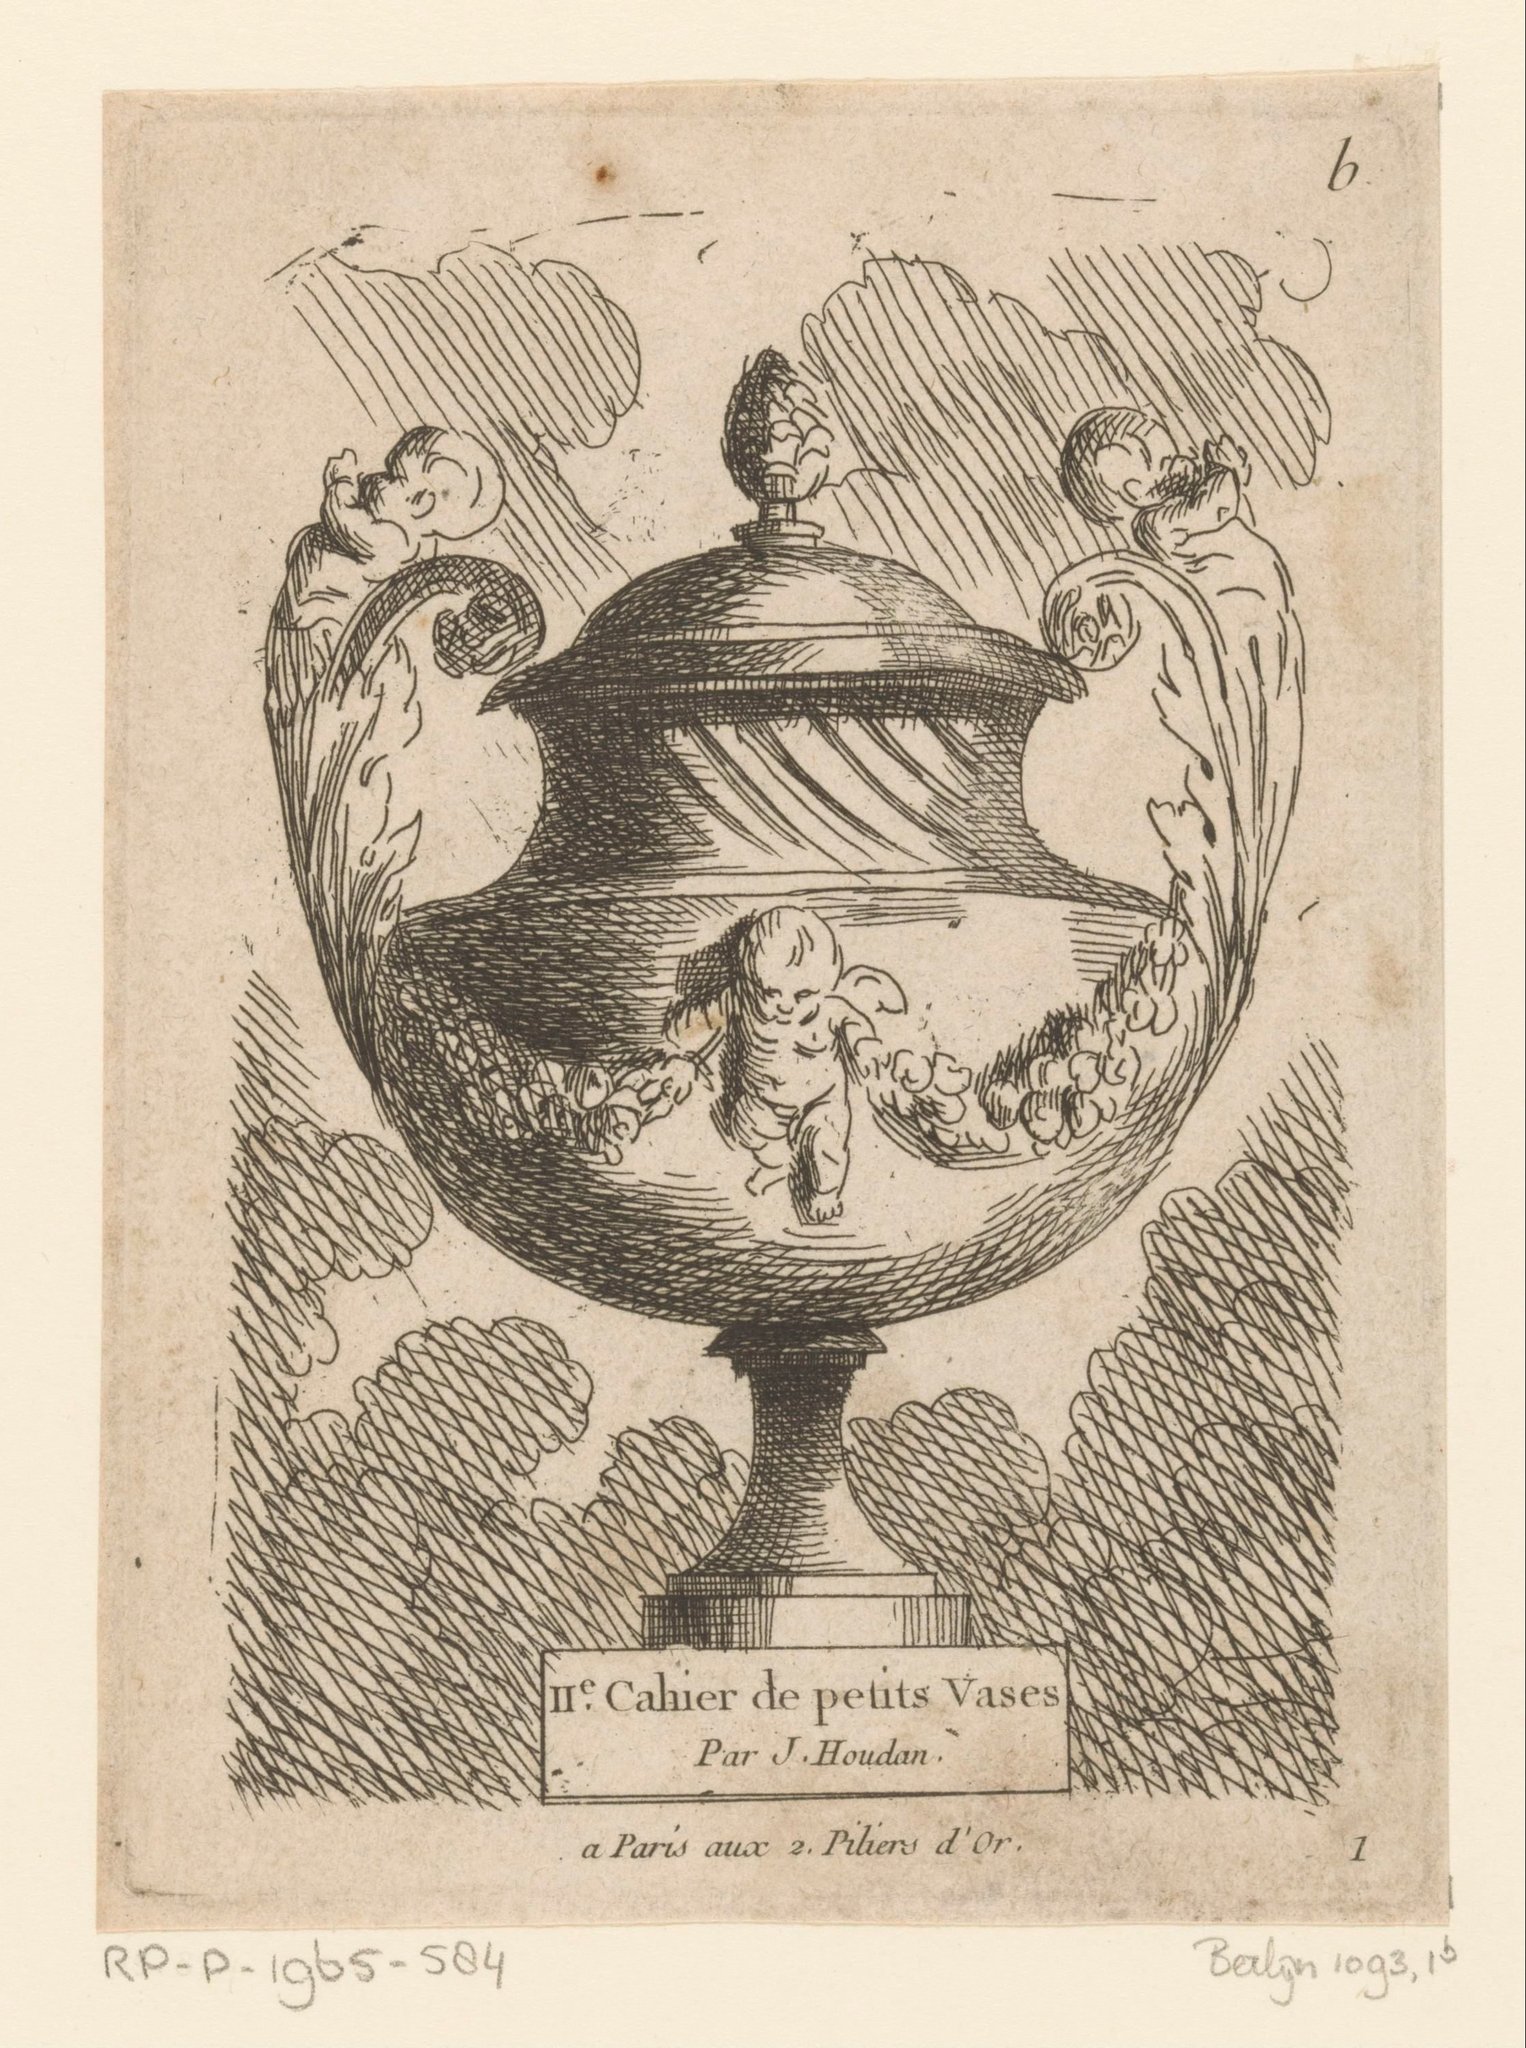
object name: titelprent, frontispice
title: Vaas met putti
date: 1770-1780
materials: paper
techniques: etching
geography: paris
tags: vase ~ ornament, cupids: 'amores', 'amoretti', 'putti'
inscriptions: collector's mark: Lugt 2228, collector's mark: Lugt 2760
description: Een vaas met drie putti en een dennenappel.